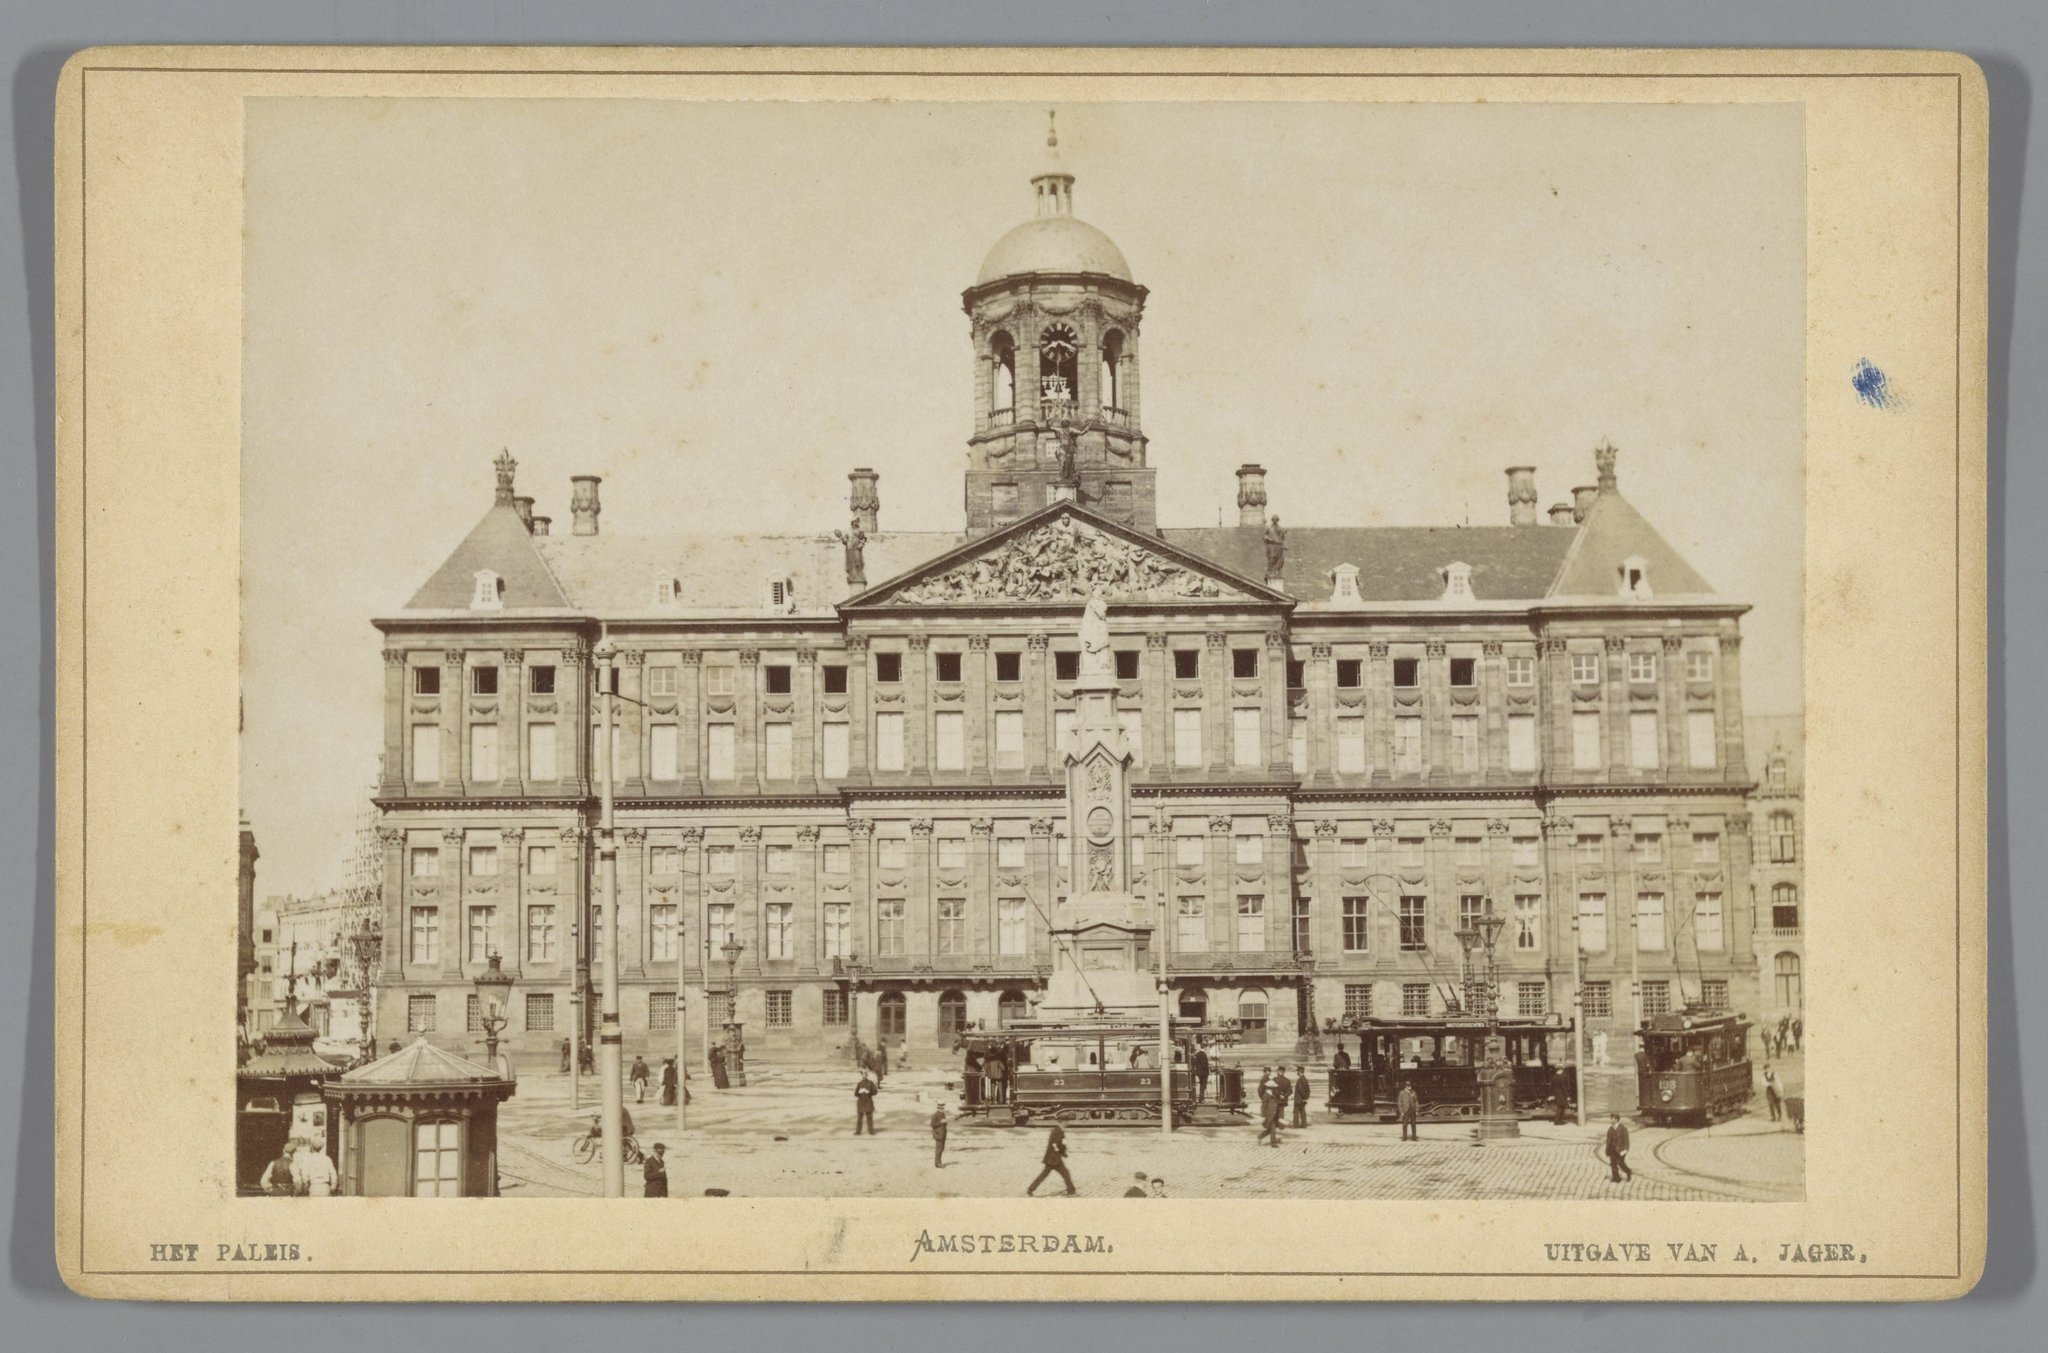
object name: cabinet photograph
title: Amsterdam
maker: andries jager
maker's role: publisher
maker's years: 1825-1905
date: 1860-1890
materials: cardboard, photographic support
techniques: albumen print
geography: amsterdam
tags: square, place, circus, etc., palace, royal palace of amsterdam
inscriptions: annotation: ‘waa[...]/ weg 1911 of 1912’, collector's mark: ‘ARCH[IEF C. SPOOK]/ TEKENAAR’, collector's mark: ‘ARCHIEF C. S[POO]K/ TEKEN[AAR]’